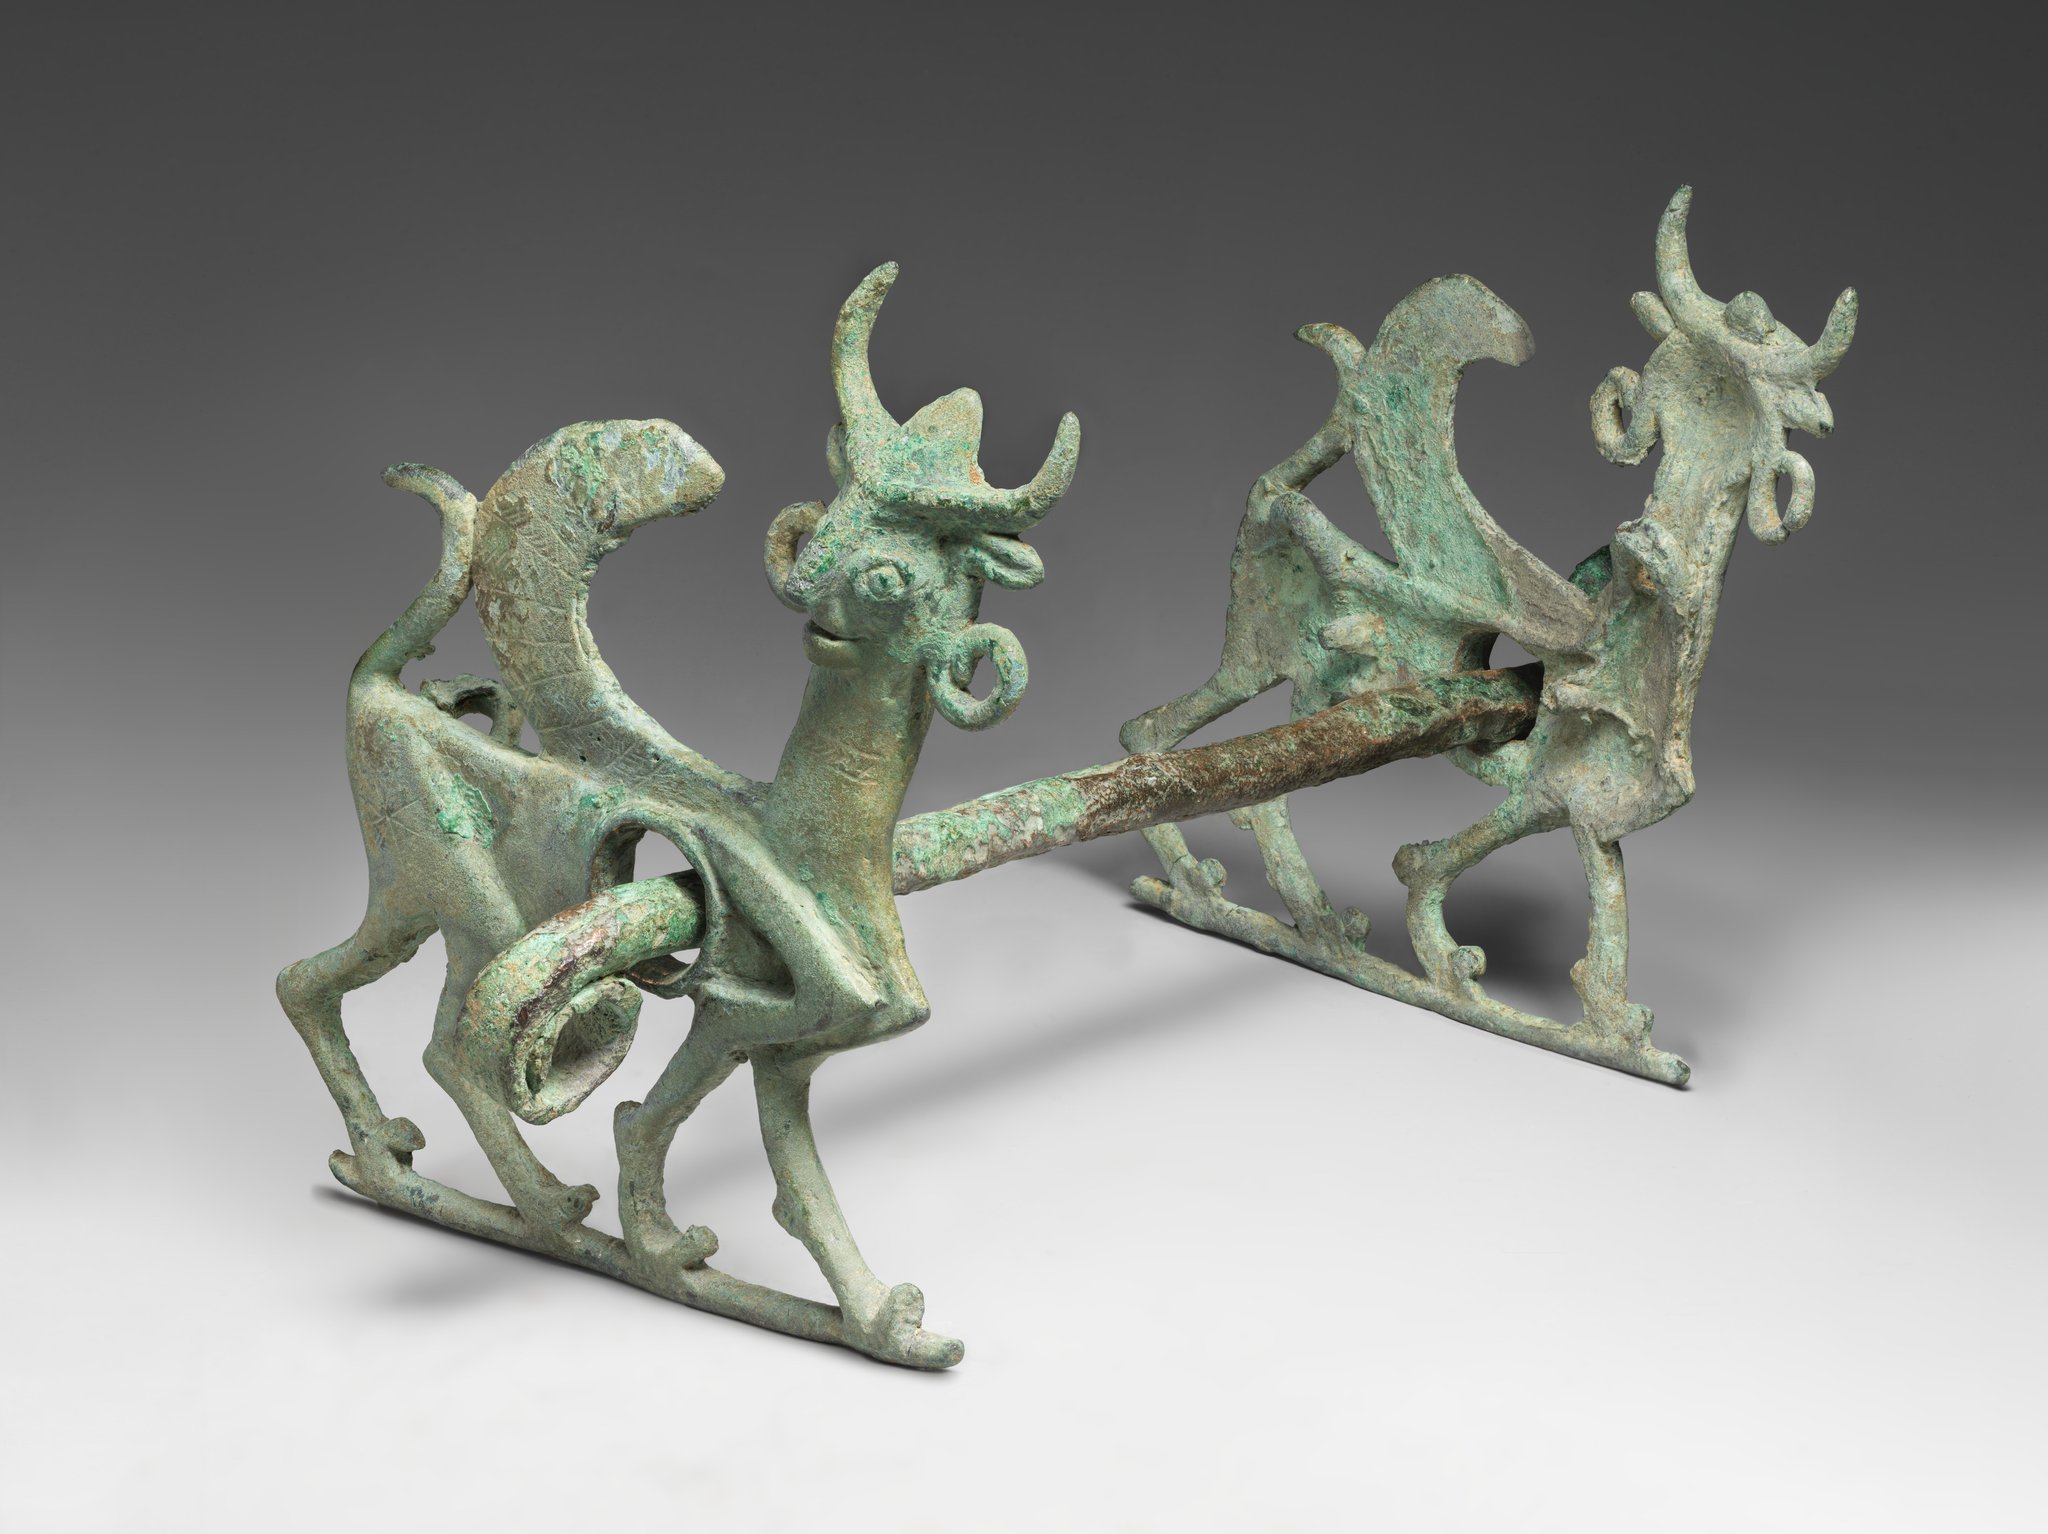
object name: horse bit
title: Horse bit with cheekpieces in form of a winged sphinx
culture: iranian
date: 800-601 BCE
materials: bronze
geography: iran, probably from luristan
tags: sphinx